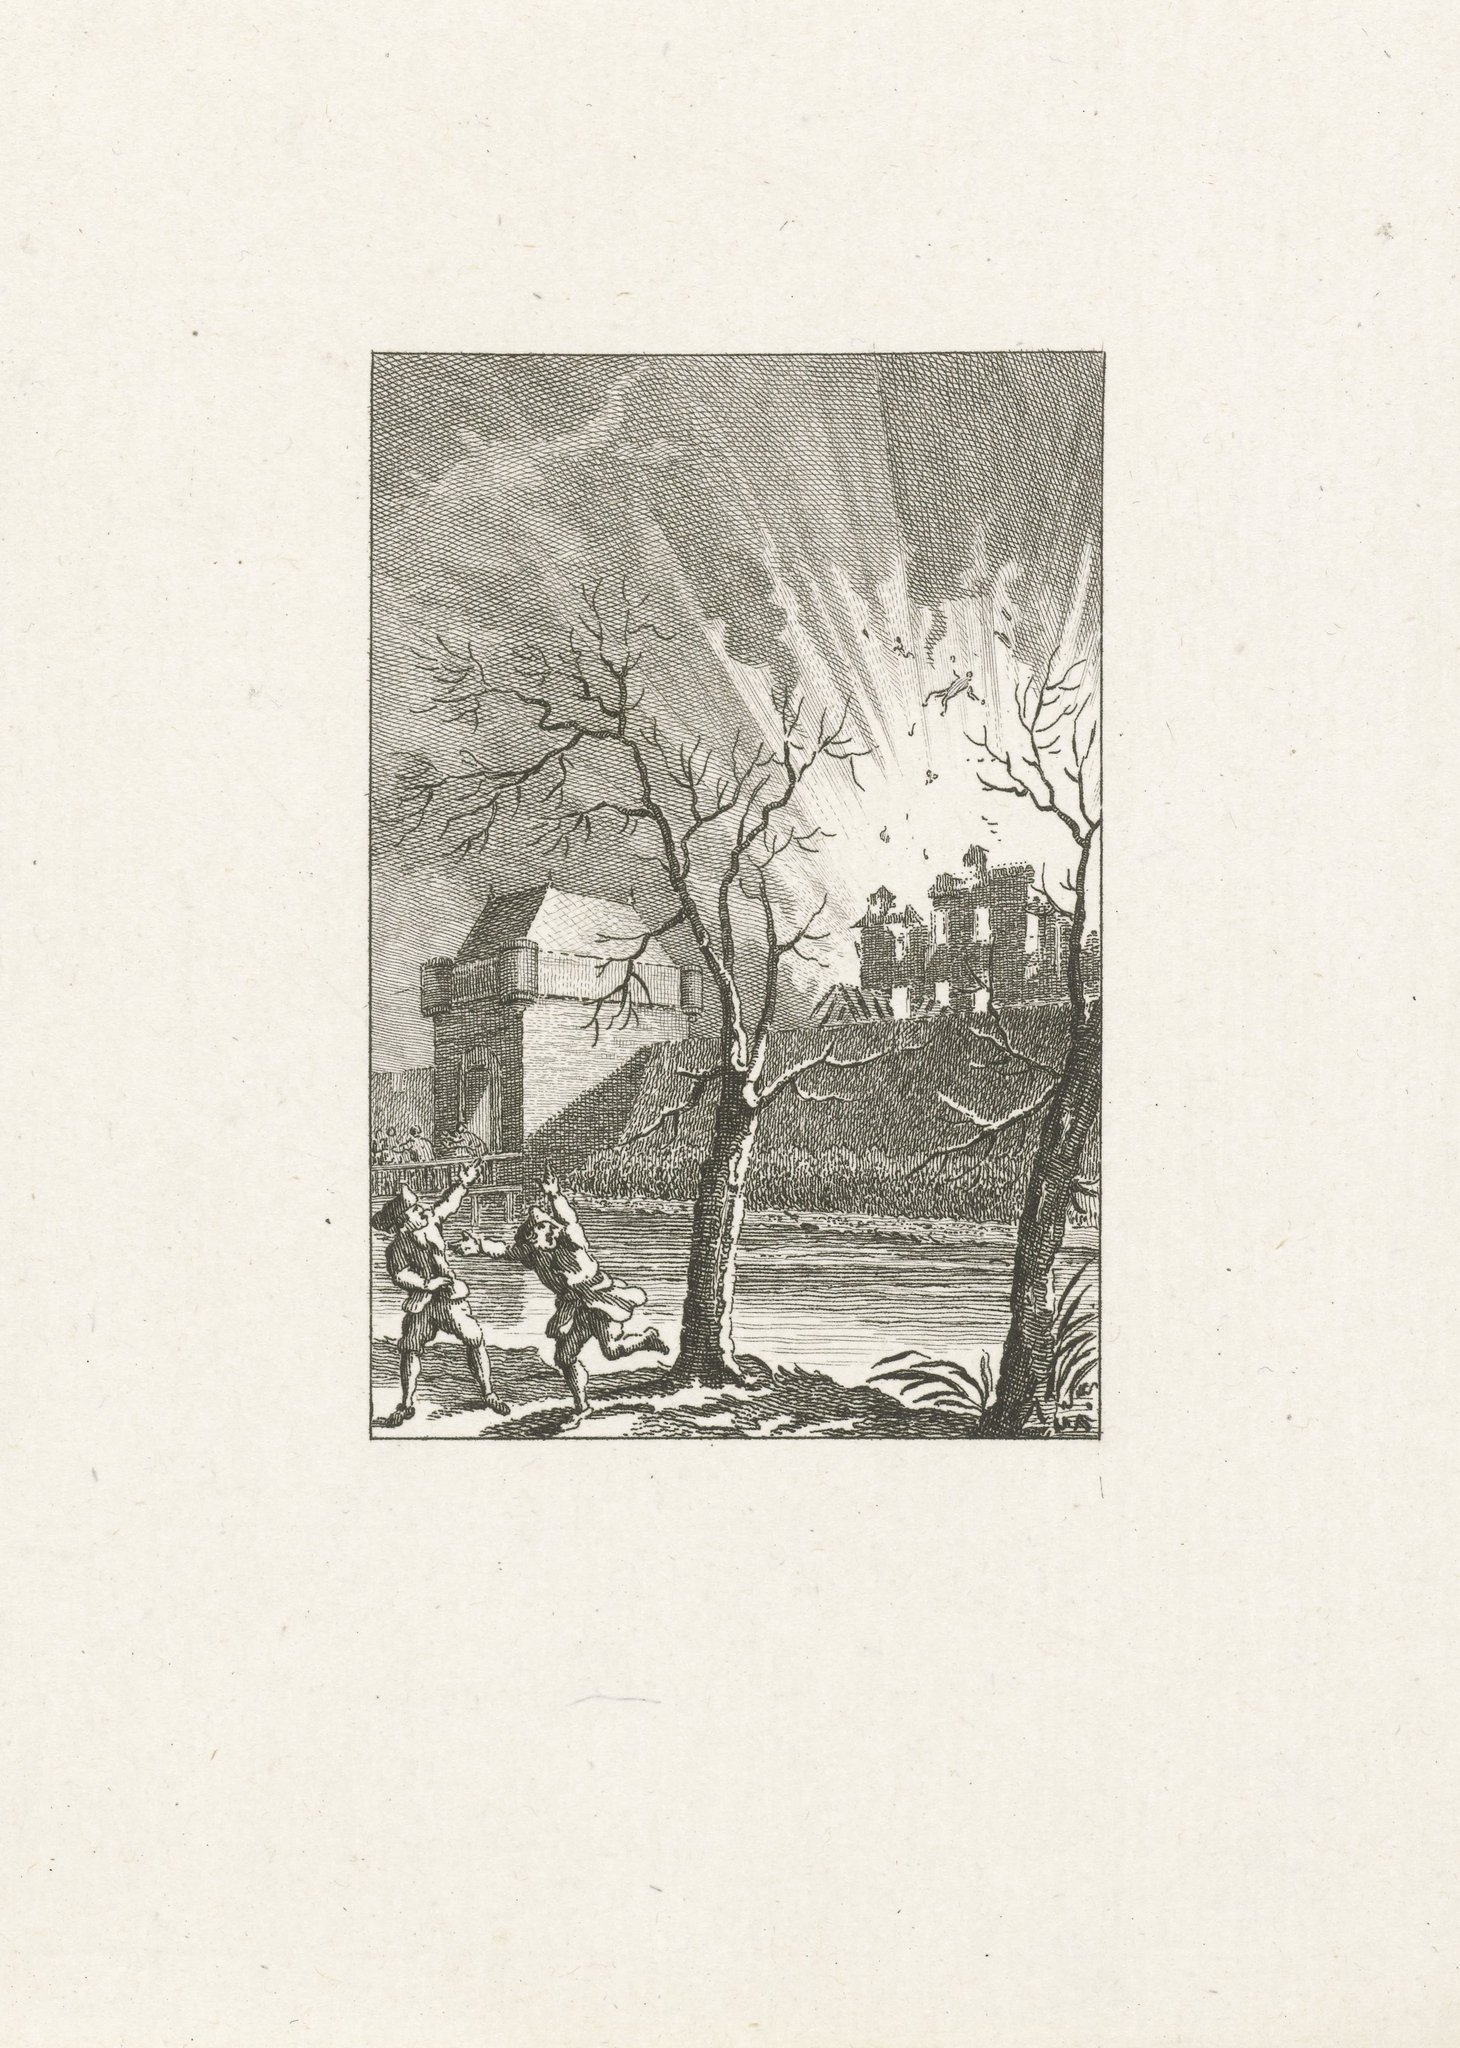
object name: print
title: Ontploffing van het kruitmagazijn te Maastricht, 1761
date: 1783-1795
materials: paper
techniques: etching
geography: northern netherlands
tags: gunpowder disaster, maastricht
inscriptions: collector's mark: Lugt 2228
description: Gebruikt als illustratie in: J. Fokke, Geschiedenissen der Vereenigde Nederlanden voor de vaderlandsche jeugd, Johannes Allart, Amsterdam 1783-1795, 25 delen, dl. 12, pl. 6.